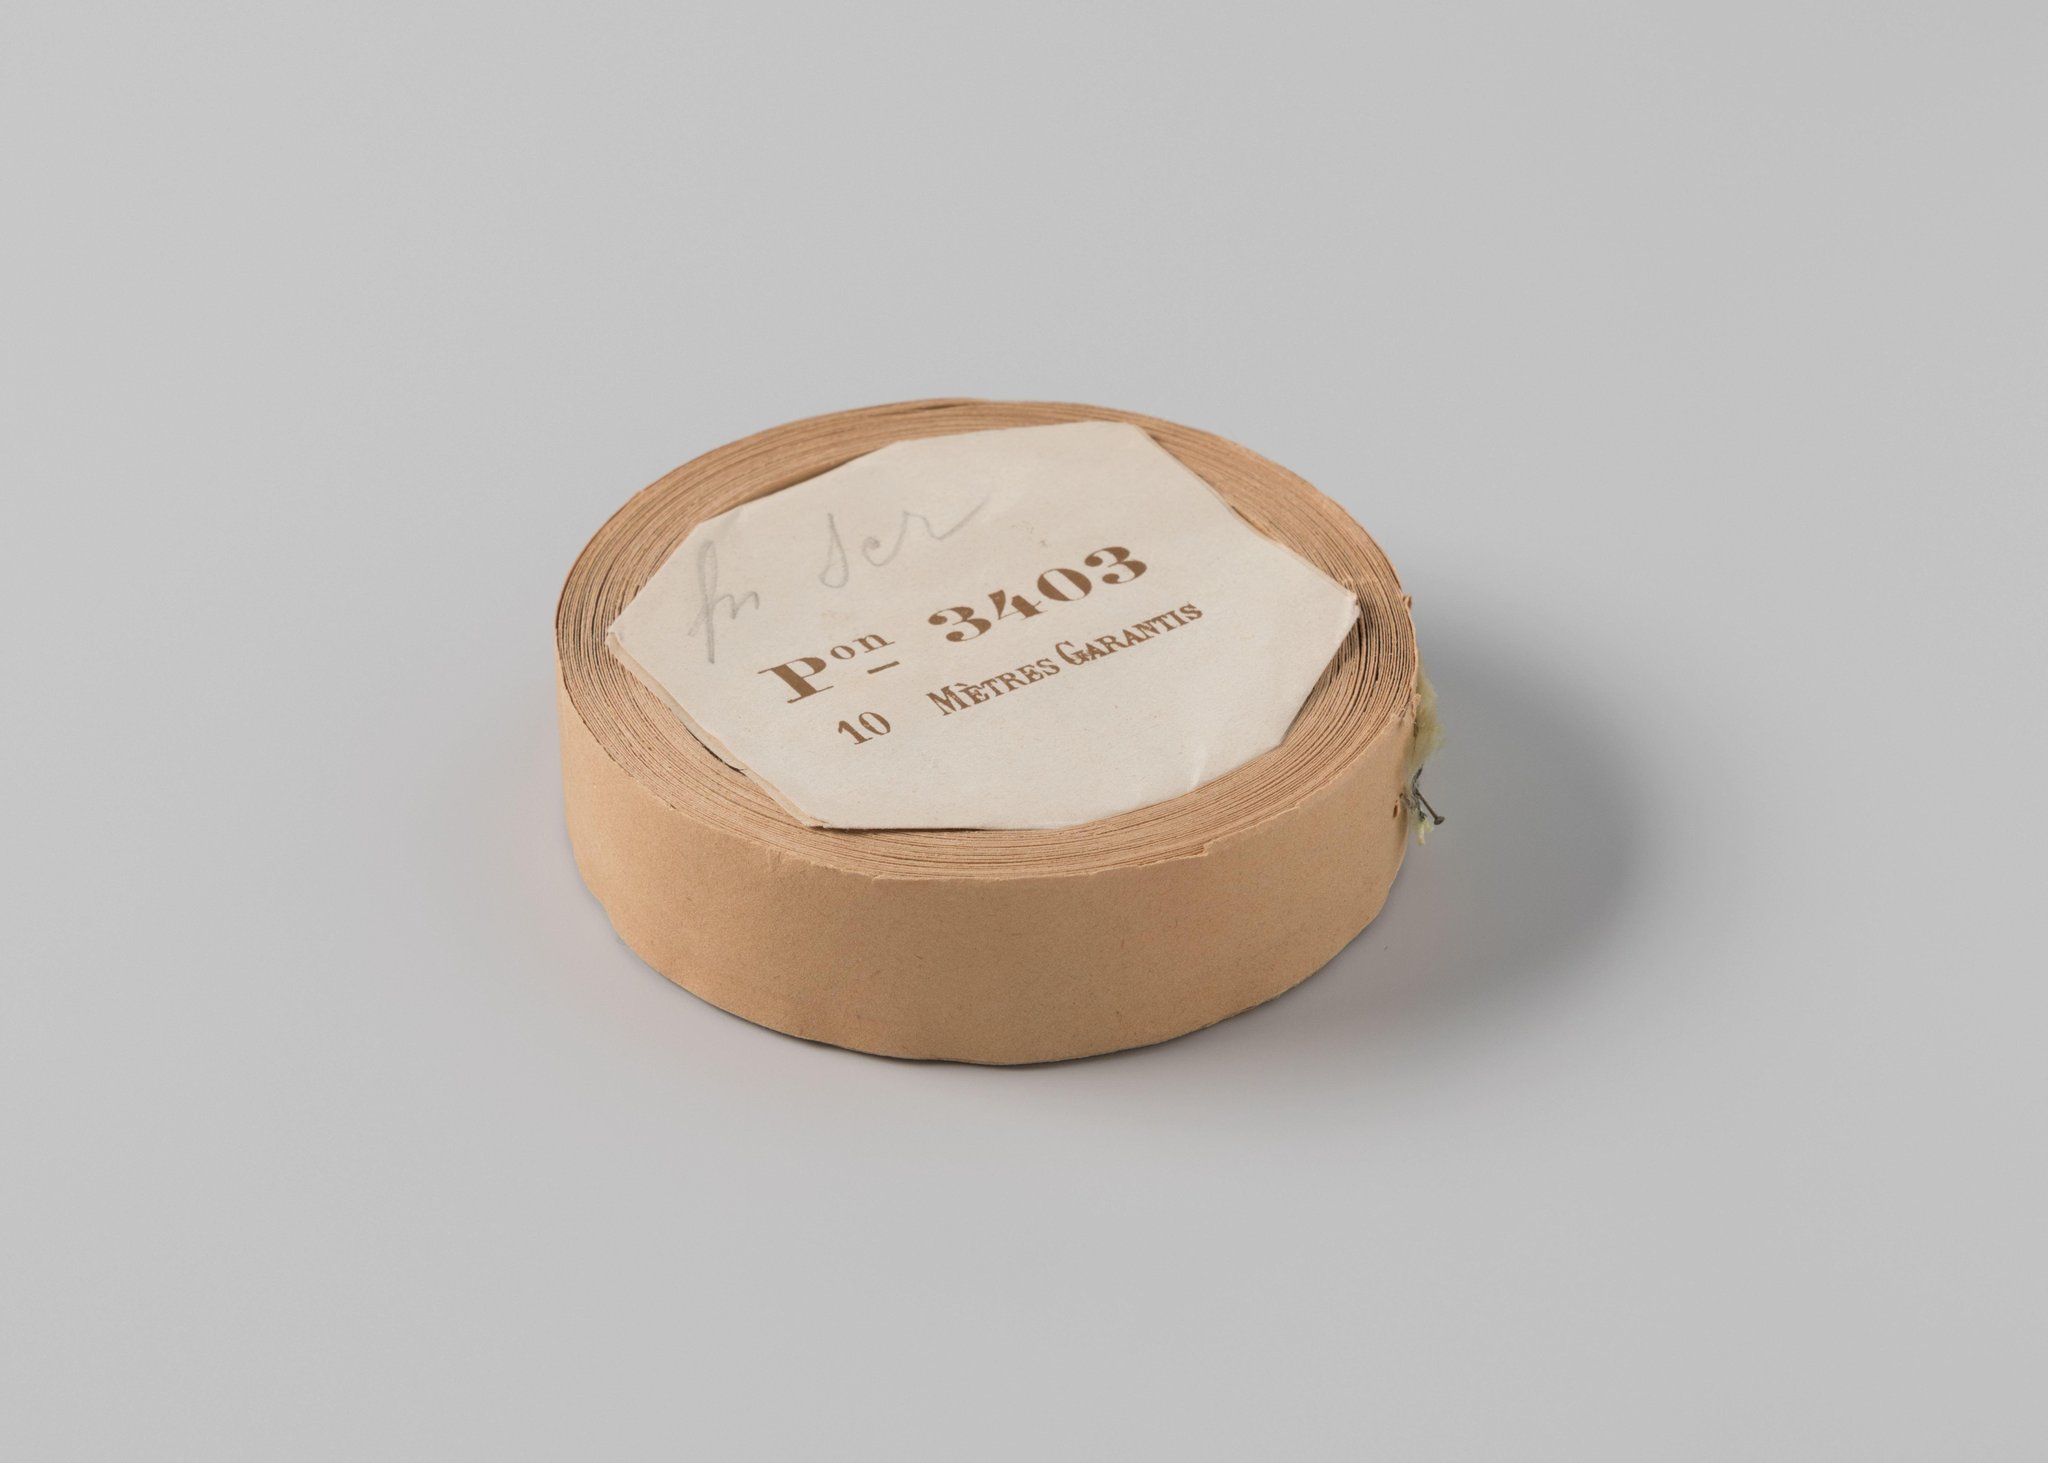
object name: rol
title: Rol met lichtgroen lint met één gerafelde zijde en drie zwarte horizontale strepen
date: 1930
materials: cardboard, paper, textile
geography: france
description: Rol met lichtgroen lint met één gerafelde zijde en drie zwarte horizontale strepen.